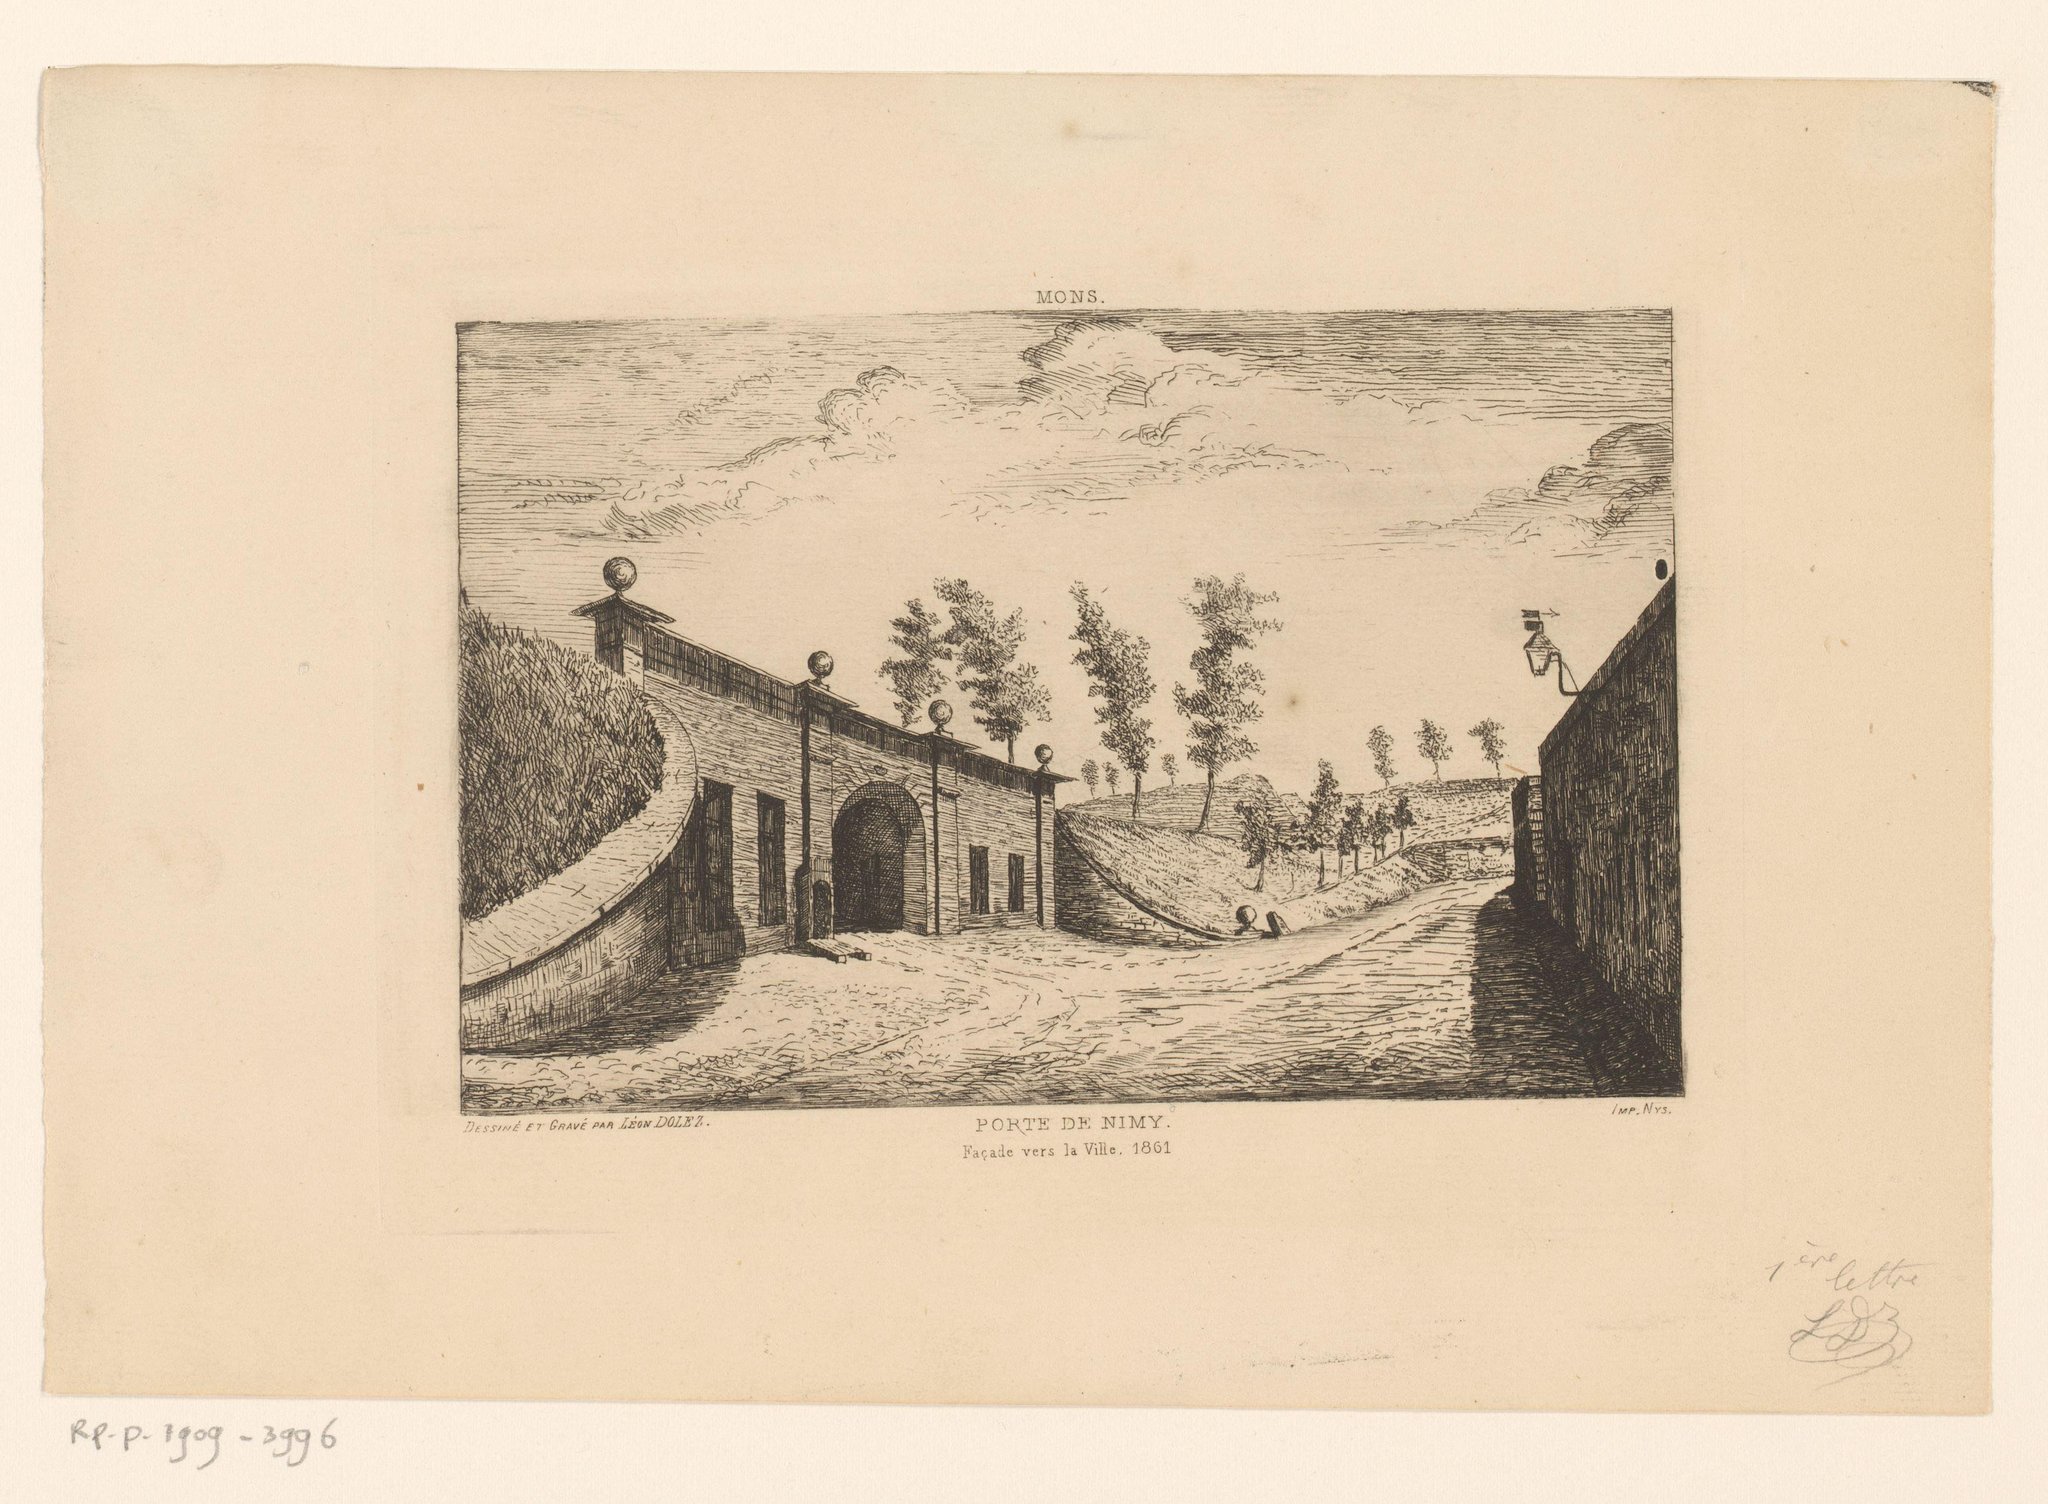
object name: print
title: Mons / Porte de Nimy, Façade vers la Ville, 1861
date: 1875-1878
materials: paper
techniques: drypoint, etching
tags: city-gate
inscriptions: collector's mark: Lugt 2228